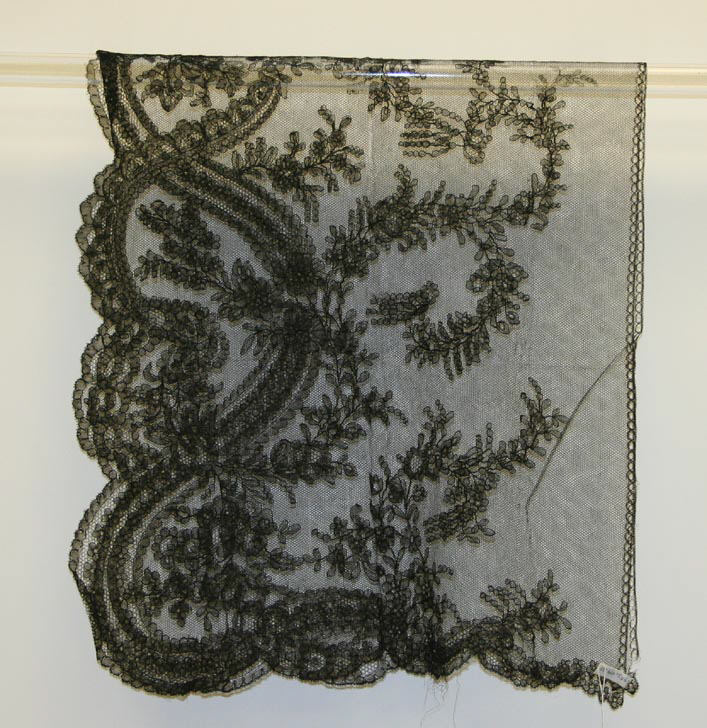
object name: scarf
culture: american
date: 1850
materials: cotton